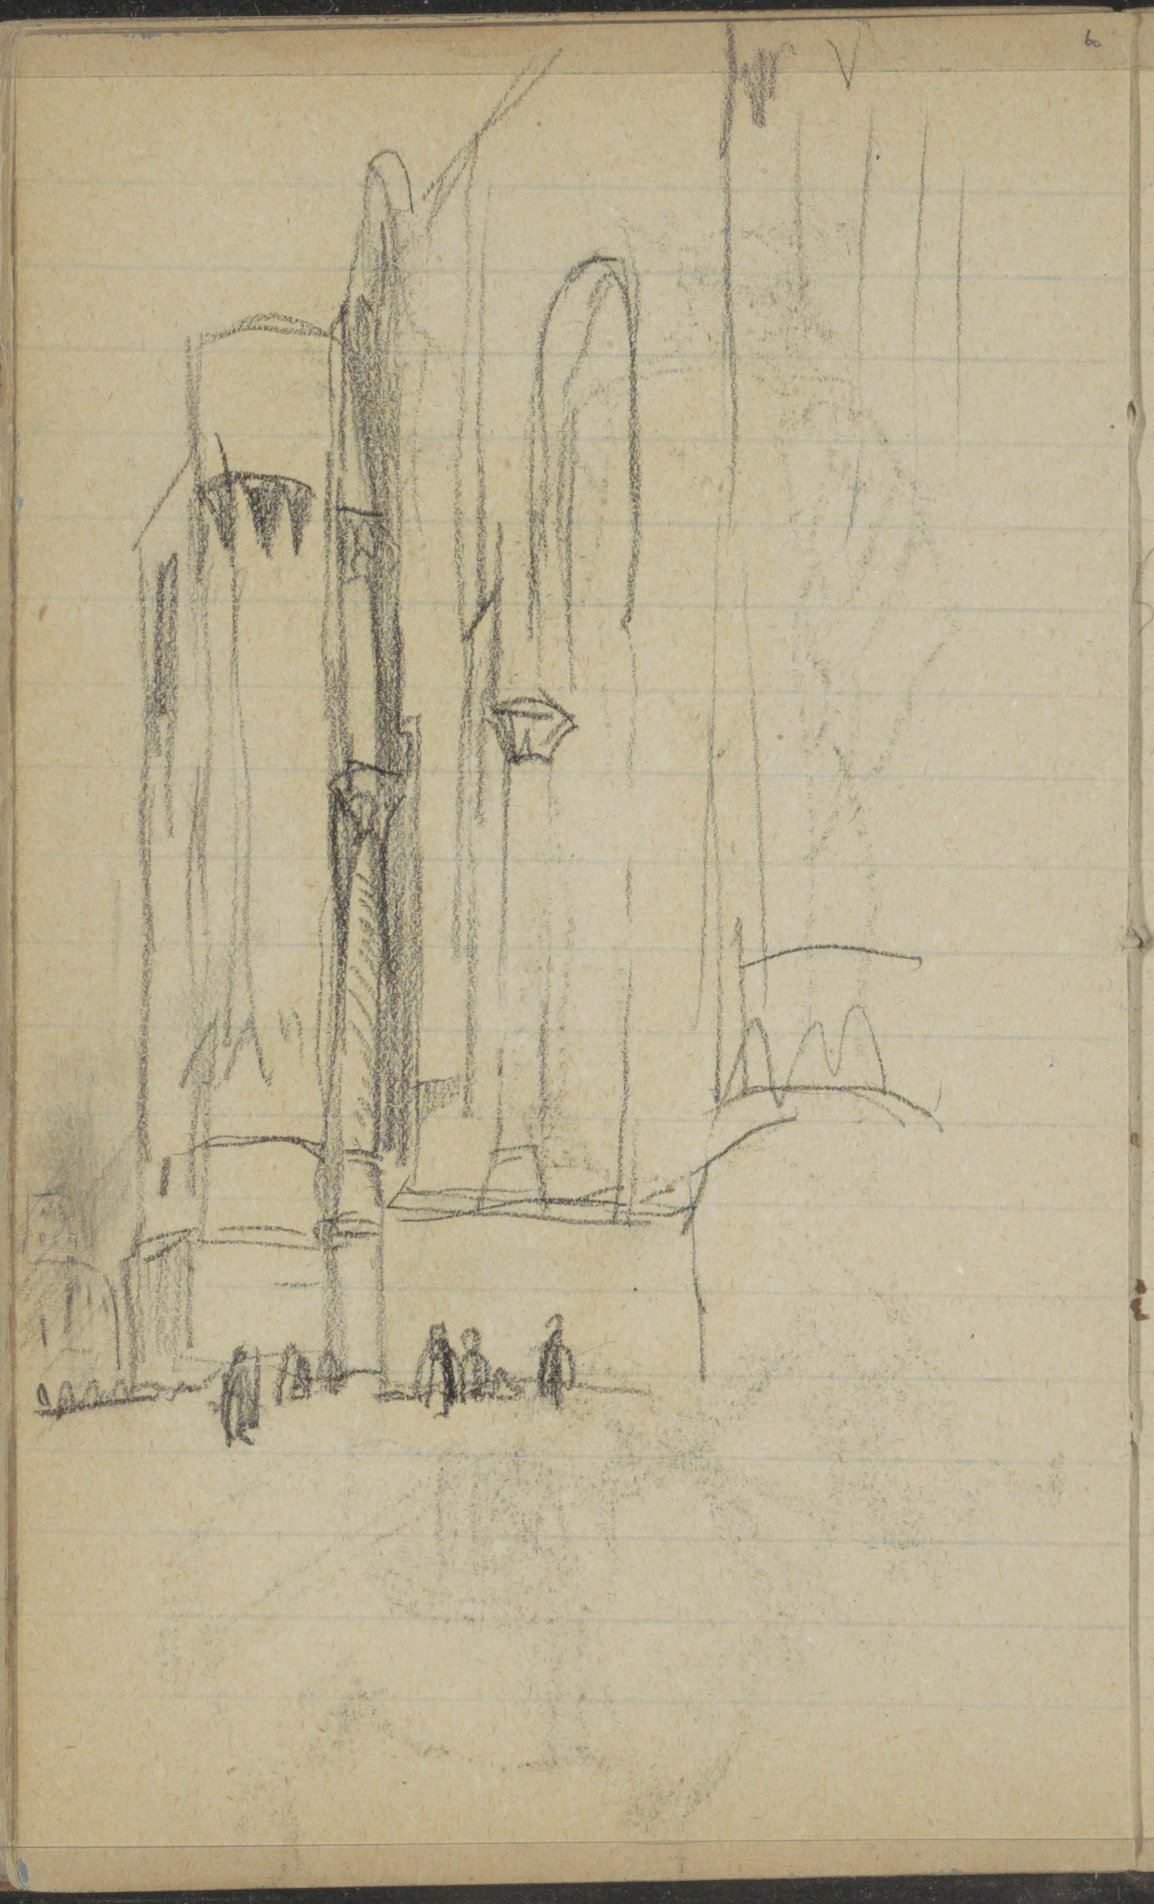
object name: sketchbook leaf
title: Figuren bij de voorgevel van gebouw, mogelijk een moskee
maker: marius bauer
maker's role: draughtsman, print maker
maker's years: 1867-1932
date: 1894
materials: chalk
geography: cairo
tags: façade (of house or building), street (+ city(-scape) with figures, staffage)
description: Pagina 60 uit een schetsboek met 48 bladen.